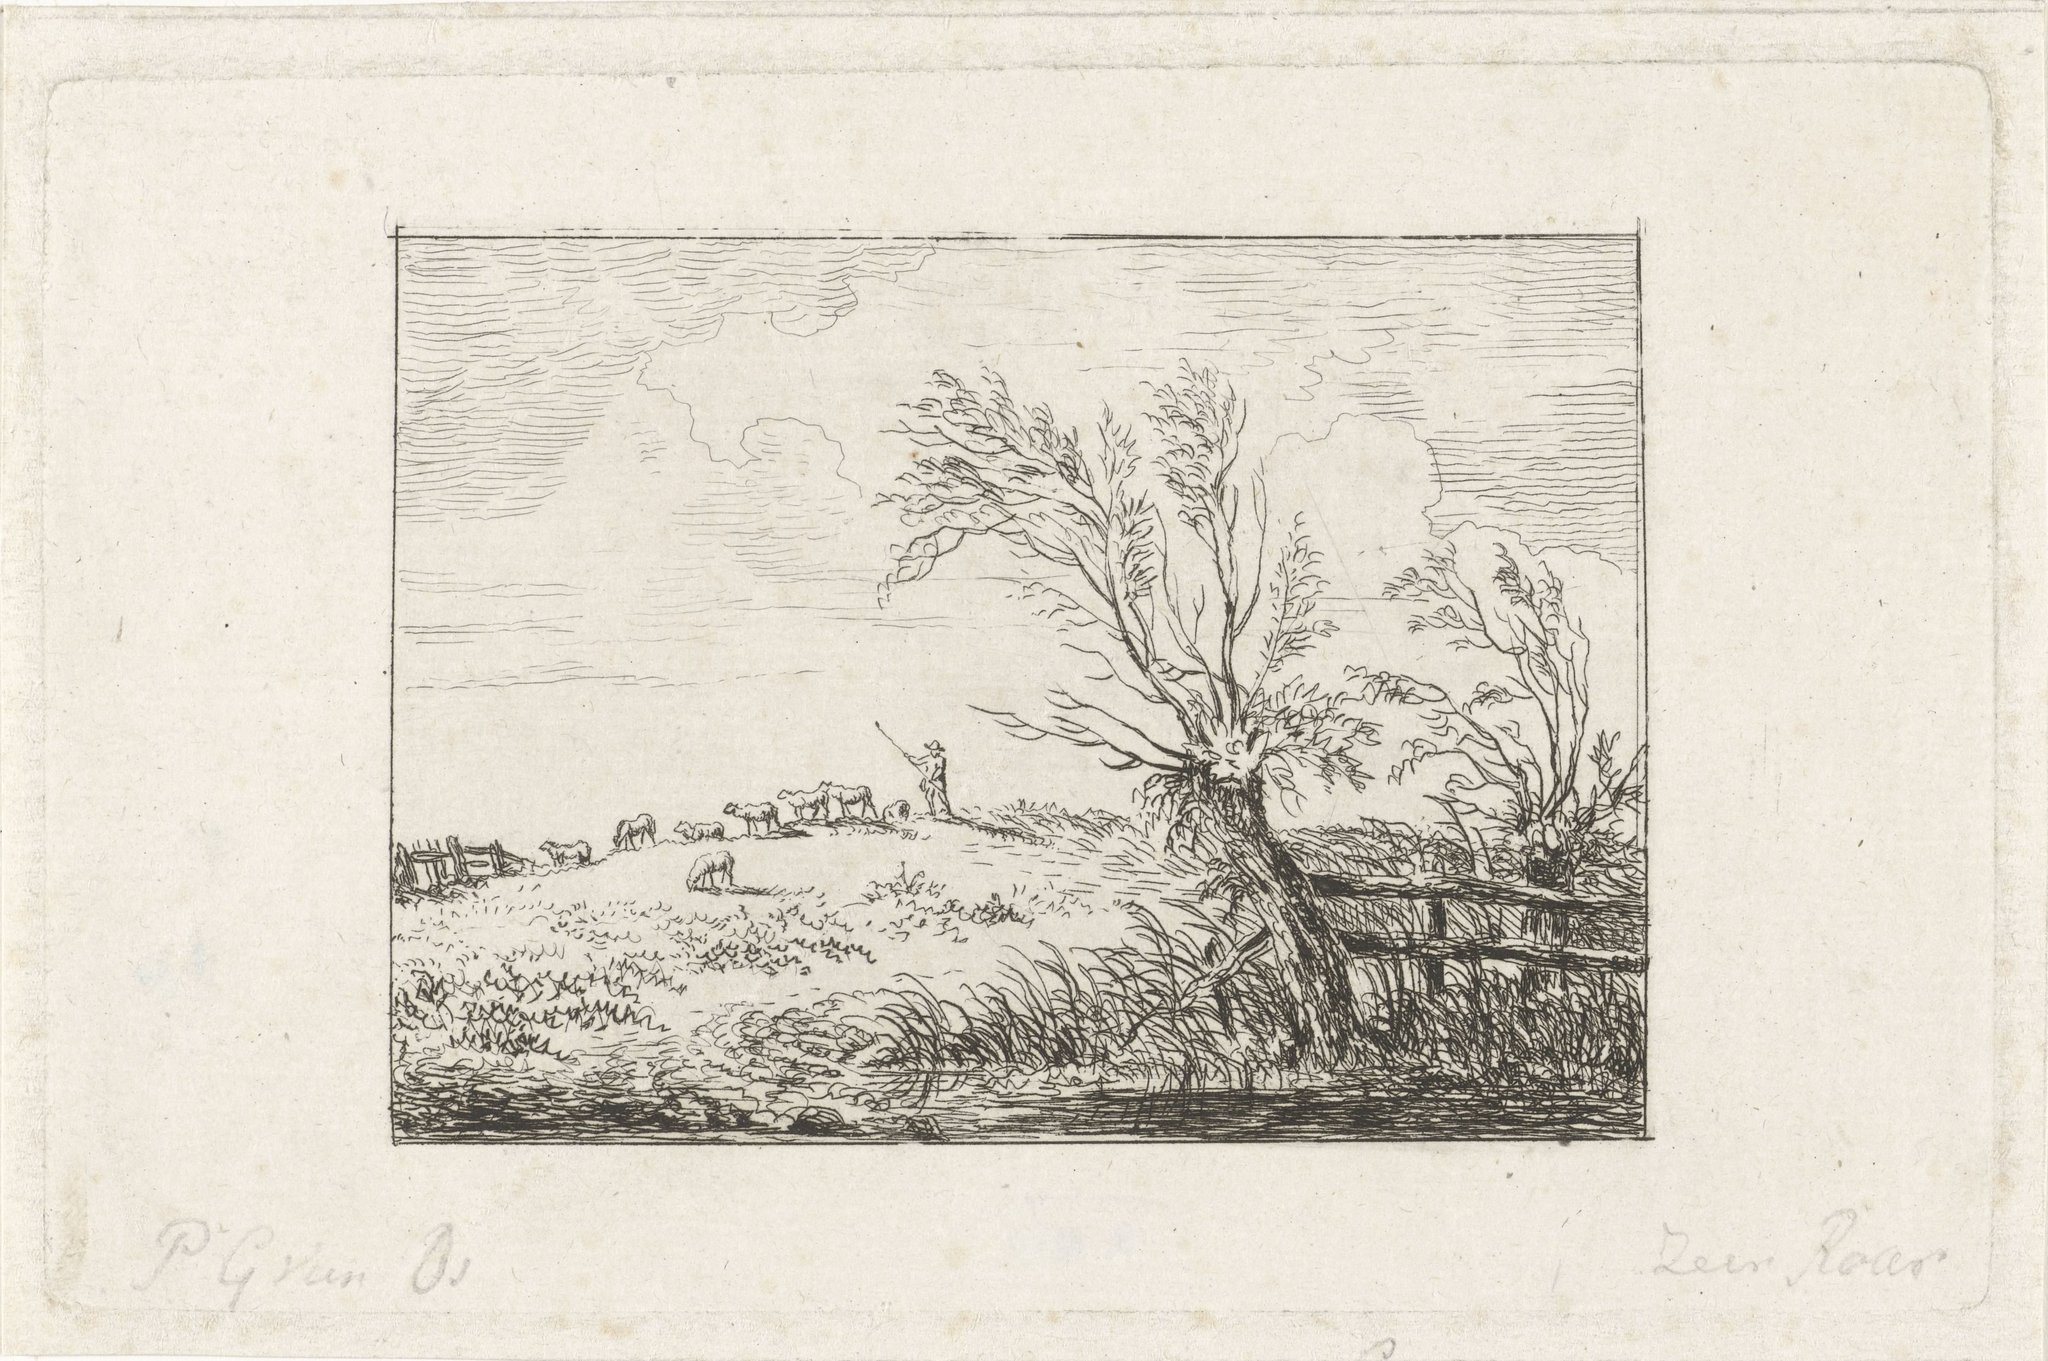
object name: print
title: Landschap met schaapskudde en wilgen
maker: pieter gerardus van os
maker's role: draughtsman, painter, print maker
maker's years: 1776-1839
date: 1791-1839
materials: paper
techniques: etching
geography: netherlands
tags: sheep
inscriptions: collector's mark: Lugt 2228